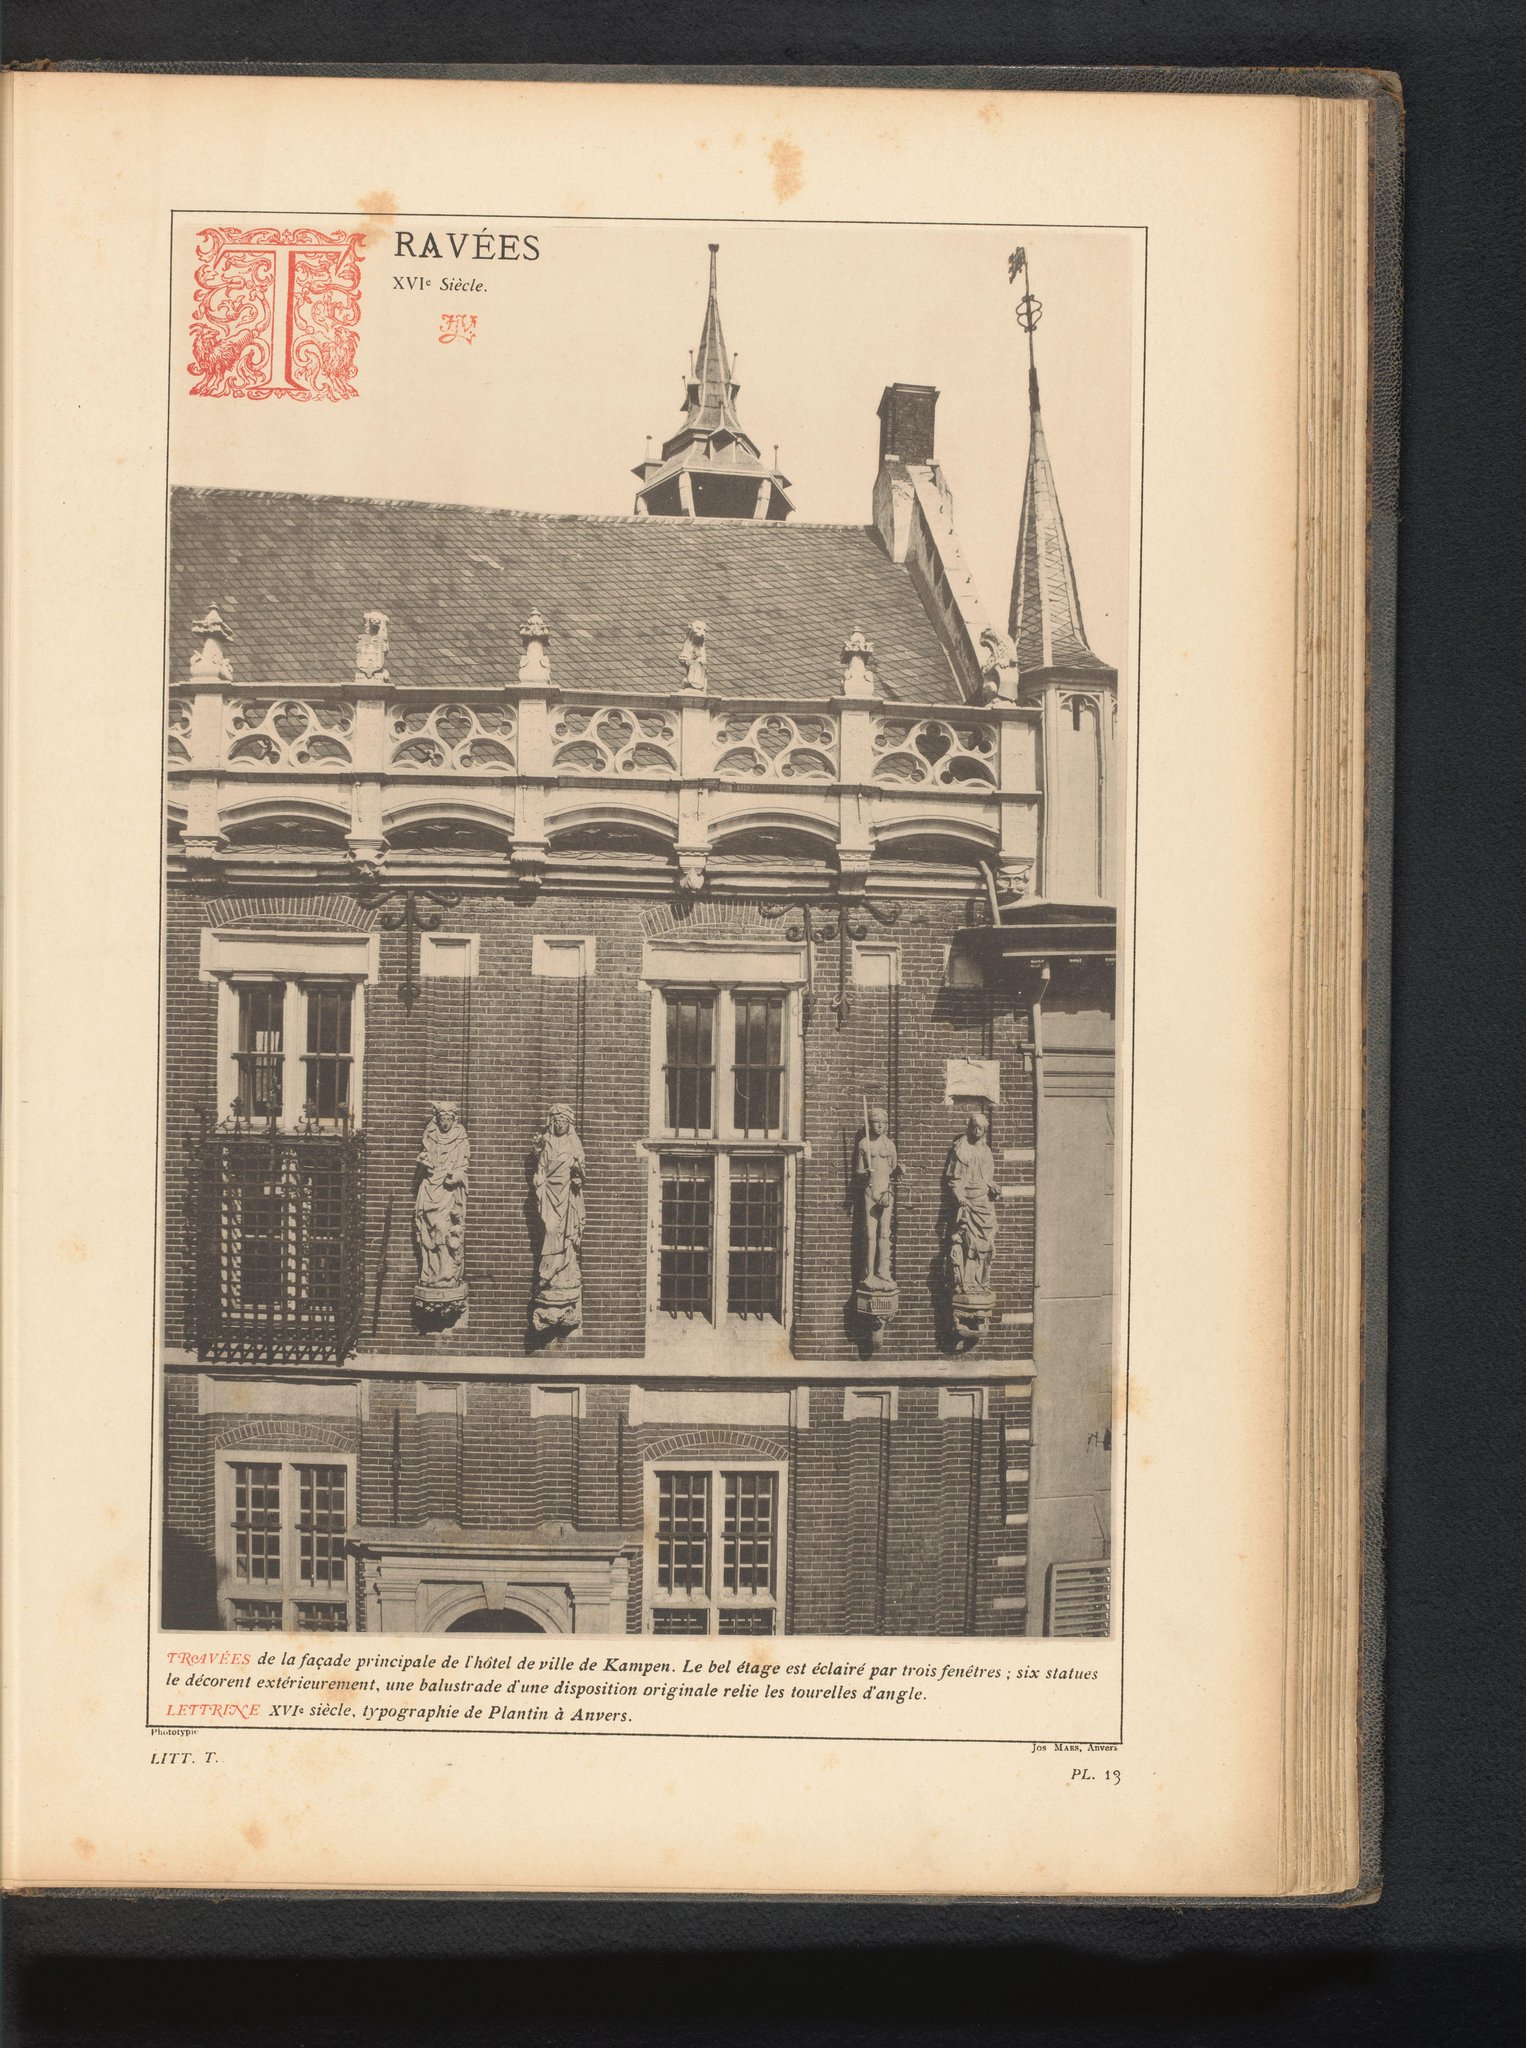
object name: page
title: Stadhuis te Kampen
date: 1876-1881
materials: paper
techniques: photograph, photolithography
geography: antwerp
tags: townhall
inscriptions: inscription: ‘TRAVÉES de la (...)’, inscription: ‘LITT. T. - PL. 13.’, monogram: ‘JJvY’